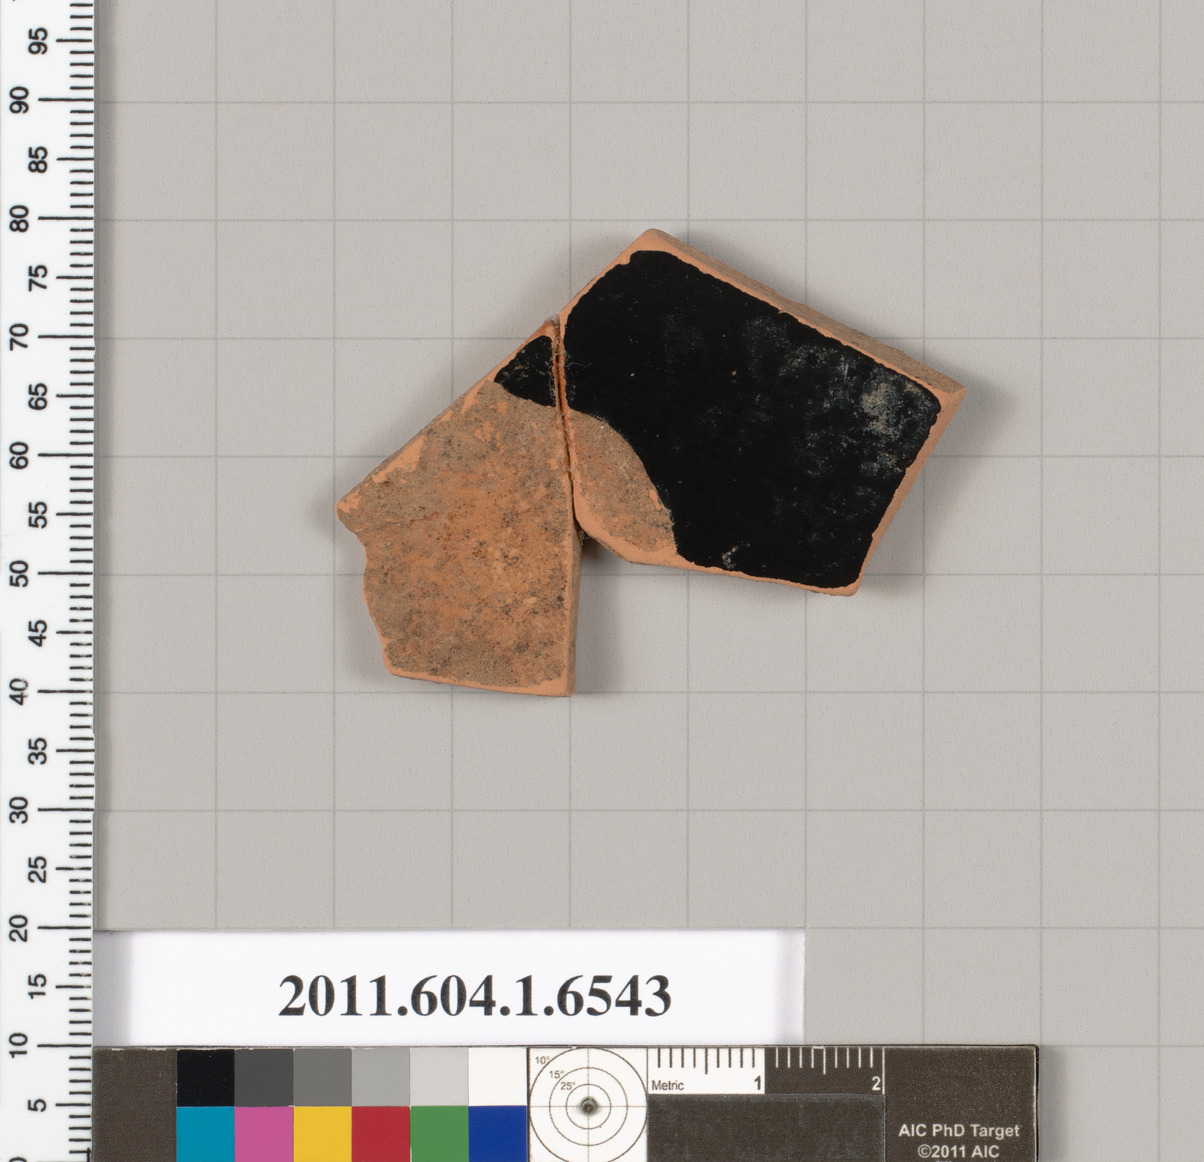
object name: kylix fragment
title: Terracotta fragment of a kylix (drinking cup)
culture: greek, attic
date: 490-480 BCE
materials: terracotta